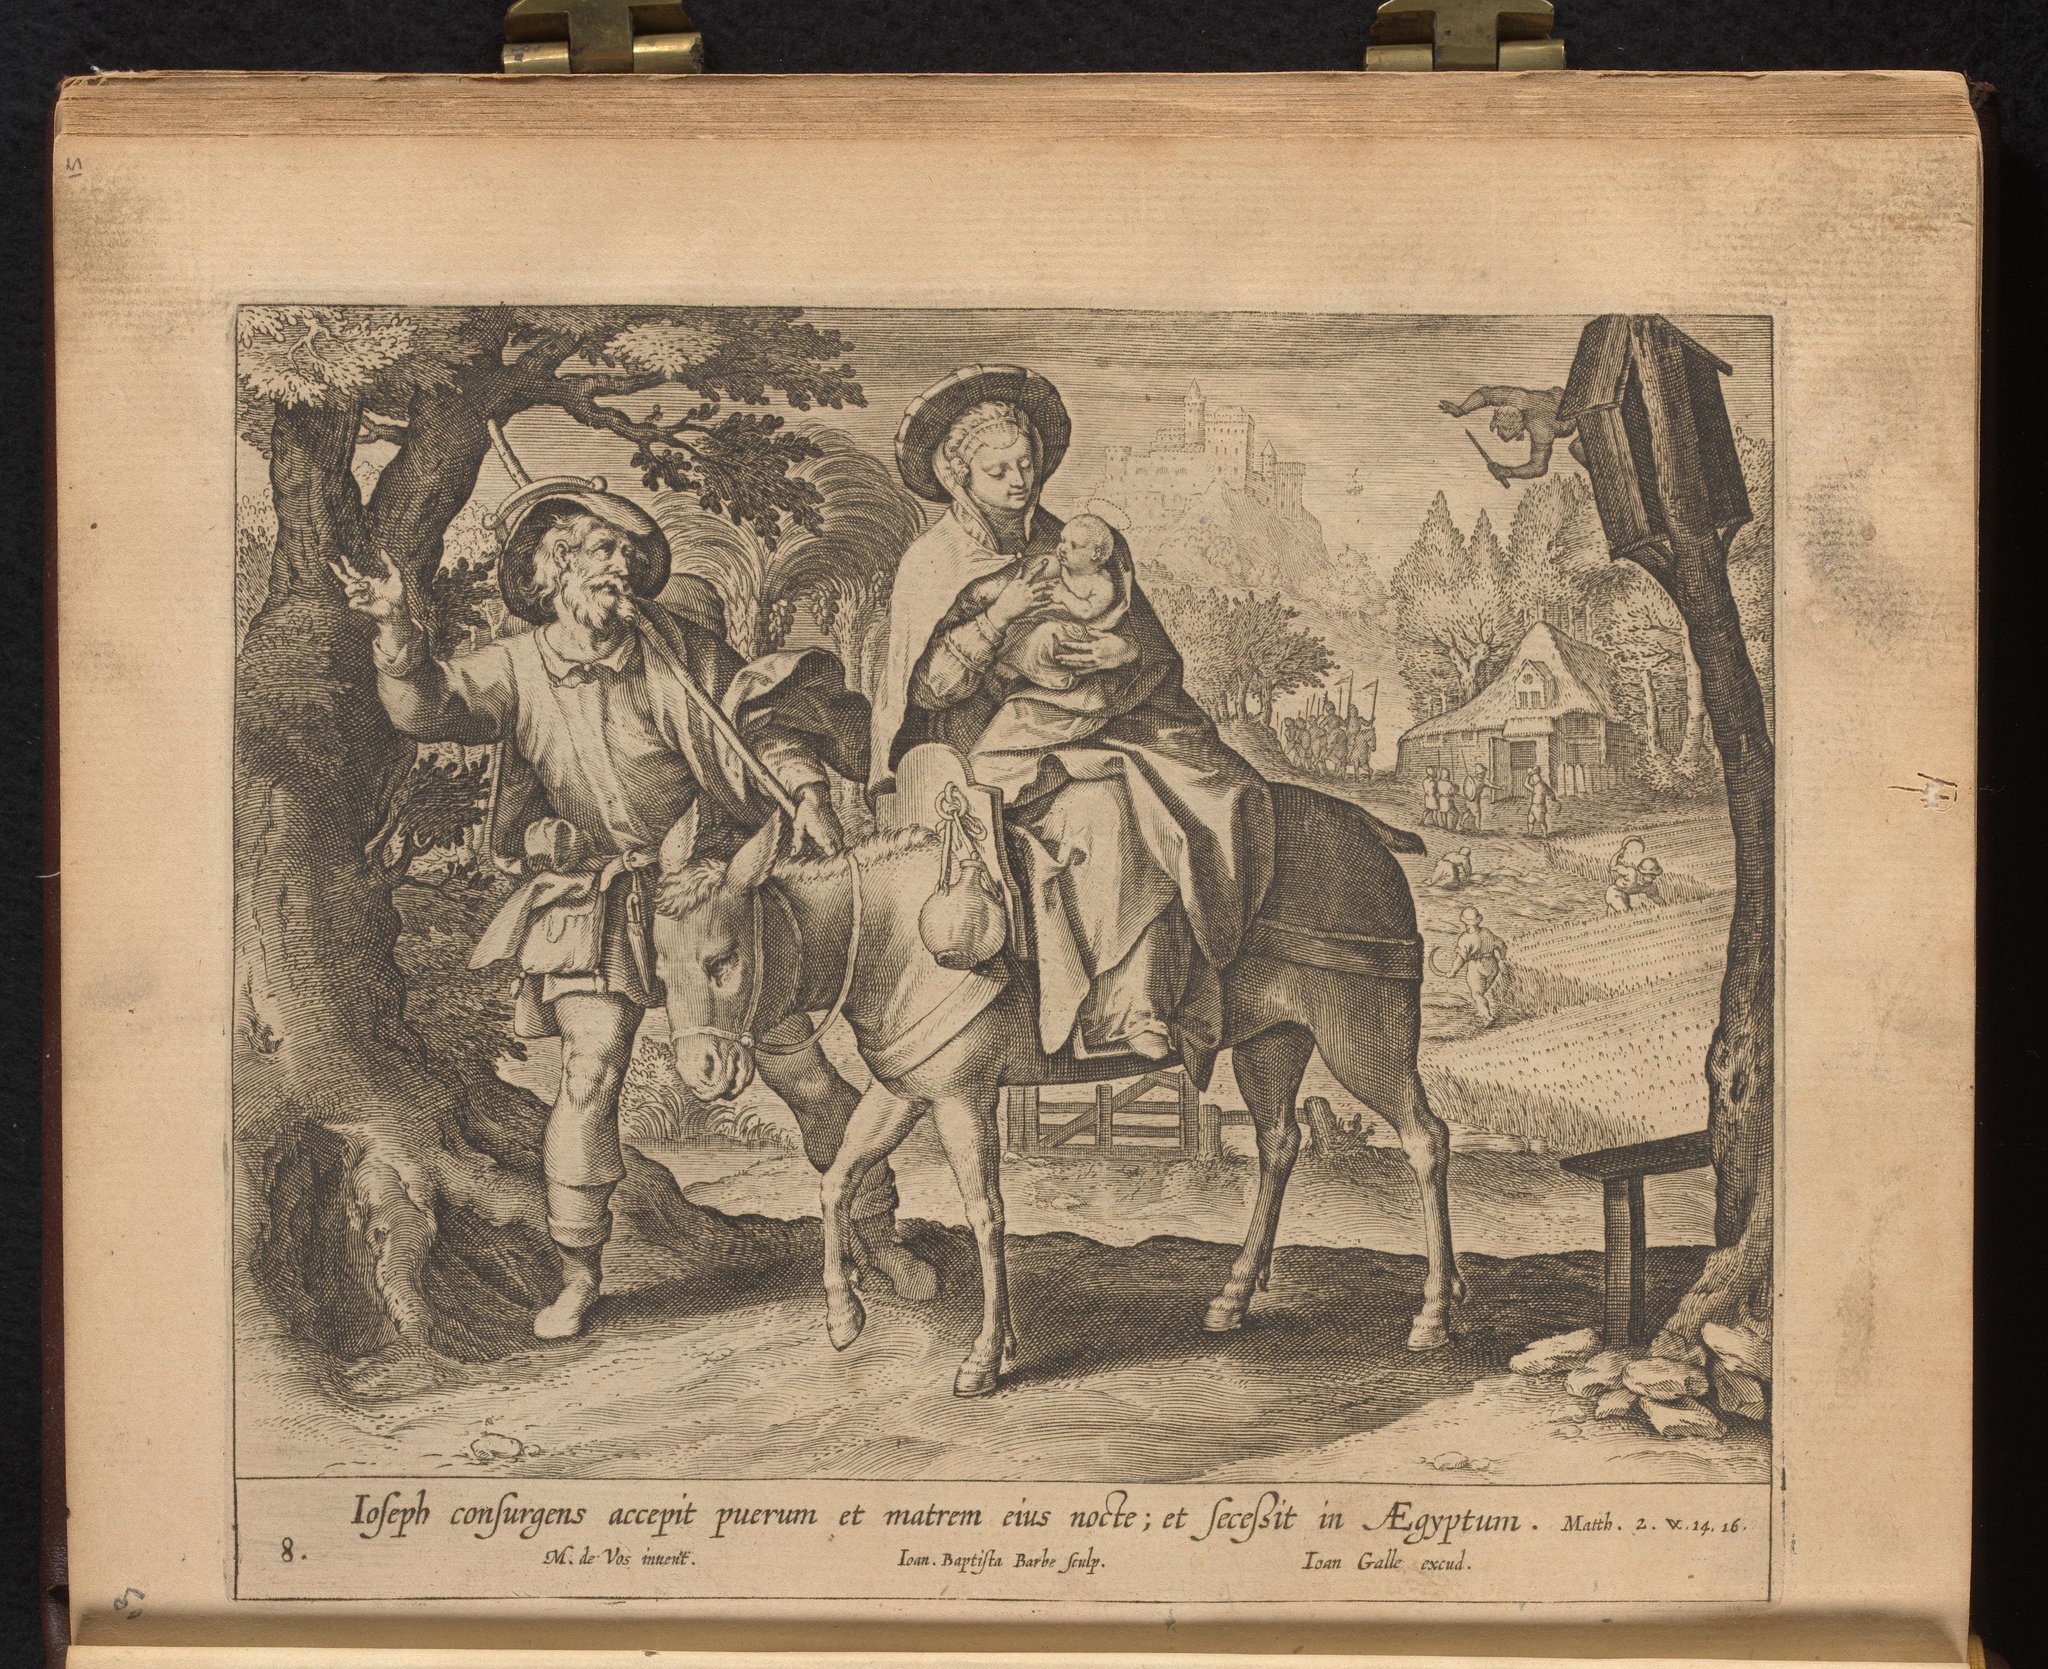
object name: print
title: Vita, passio et Resvrrectio Iesv Christi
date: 1598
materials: paper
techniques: engraving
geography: antwerp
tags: flight into egypt and miracles during the journey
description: Prent in: s.n. Aldernouwkeurigste verhandelinge der geschiedenissen van het Nieuw Testament (...). Antwerpen: Cornelis Marten Spanoghe, 1783, p. 18-19..